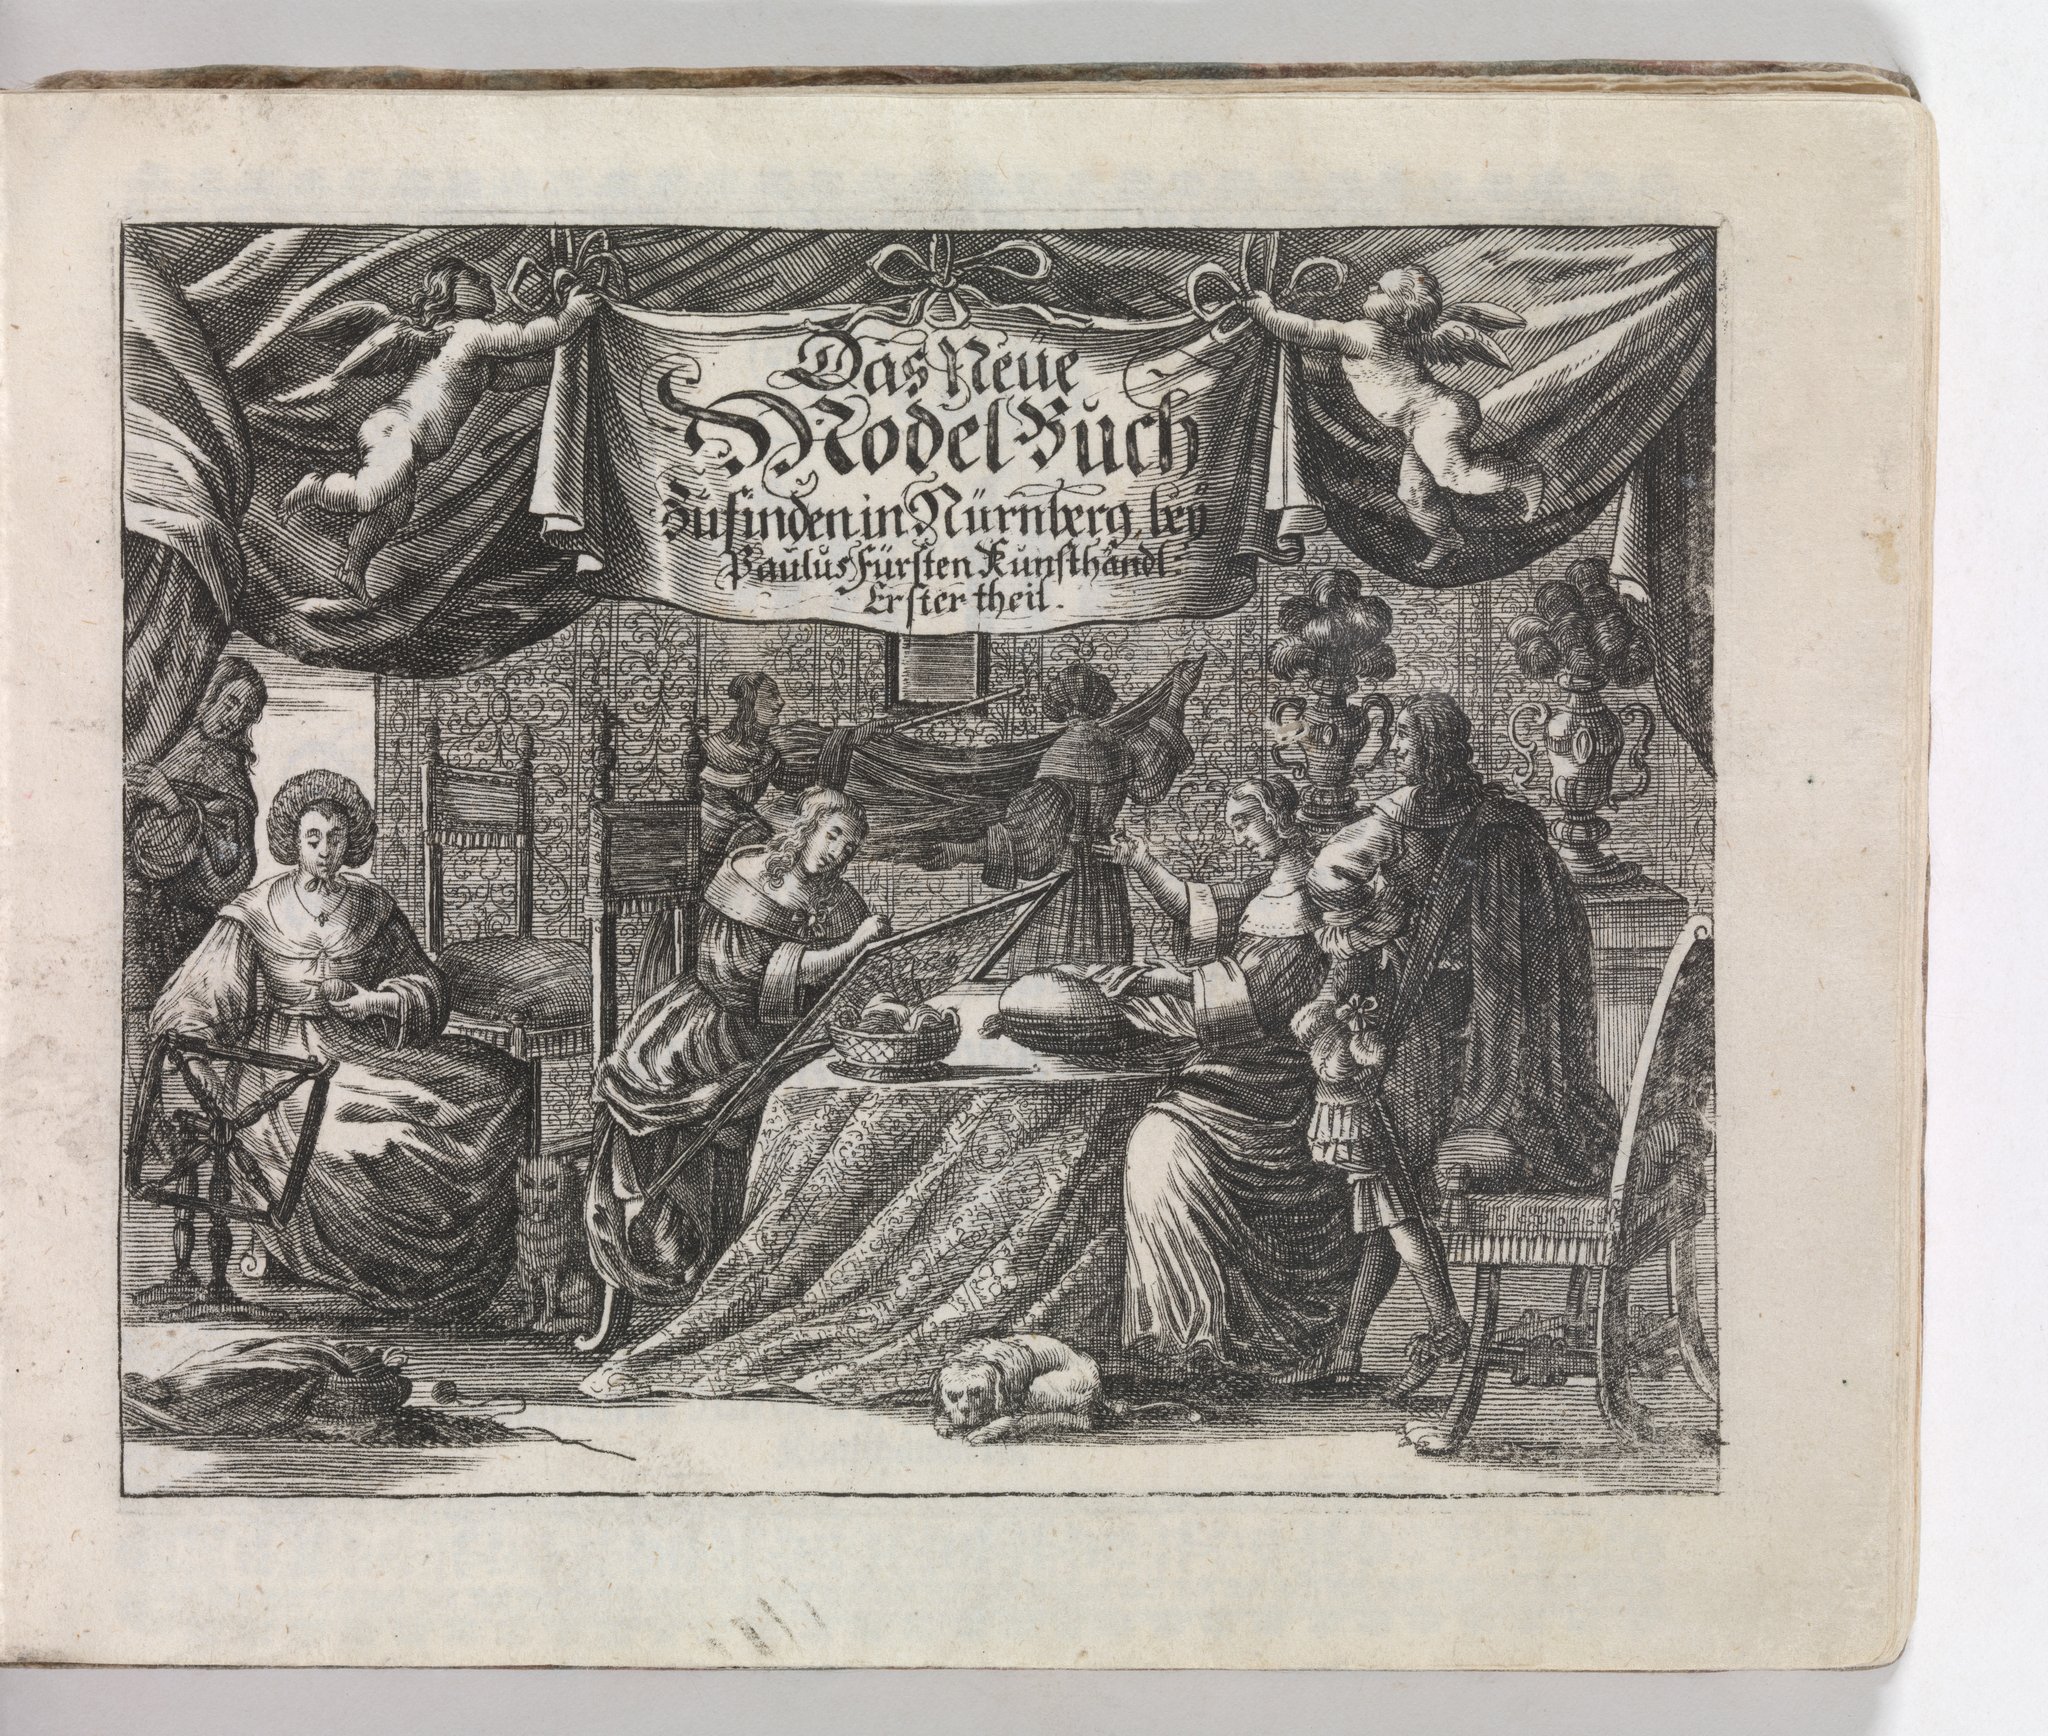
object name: book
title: Das Neüe Modelbuch. . .Erster Theil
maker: rosina helena fürst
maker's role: designer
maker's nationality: german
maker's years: 1642-1709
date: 1660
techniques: etching, woodcut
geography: germany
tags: men,women,mythical creatures,dogs,working